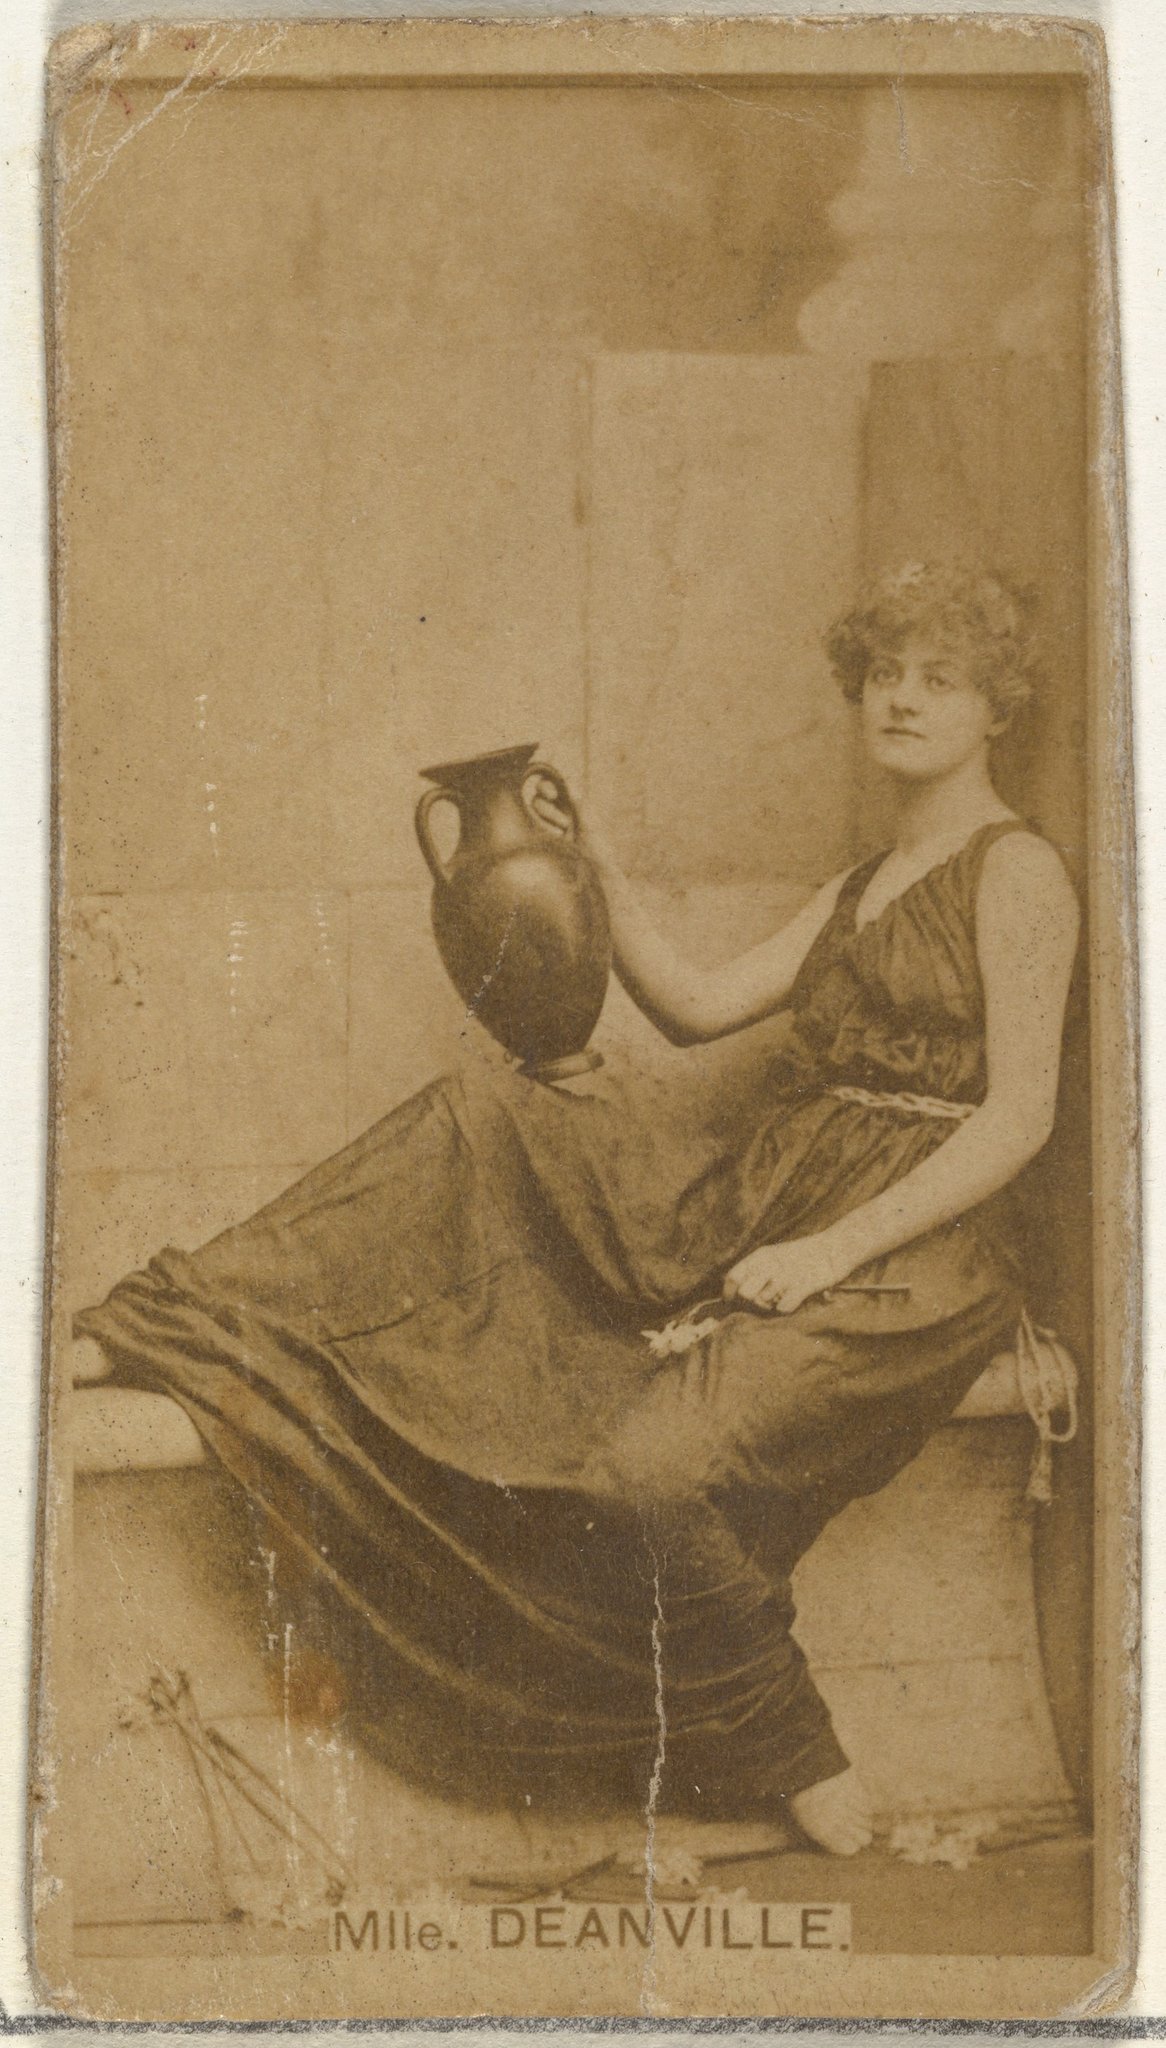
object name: photograph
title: Mlle. Deanville, from the Actors and Actresses series (N145-8) issued by Duke Sons & Co. to promote Duke Cigarettes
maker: w. duke, sons & co.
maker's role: publisher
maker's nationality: american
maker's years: 1870-1920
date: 1891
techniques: albumen silver print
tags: portraits,women,actresses